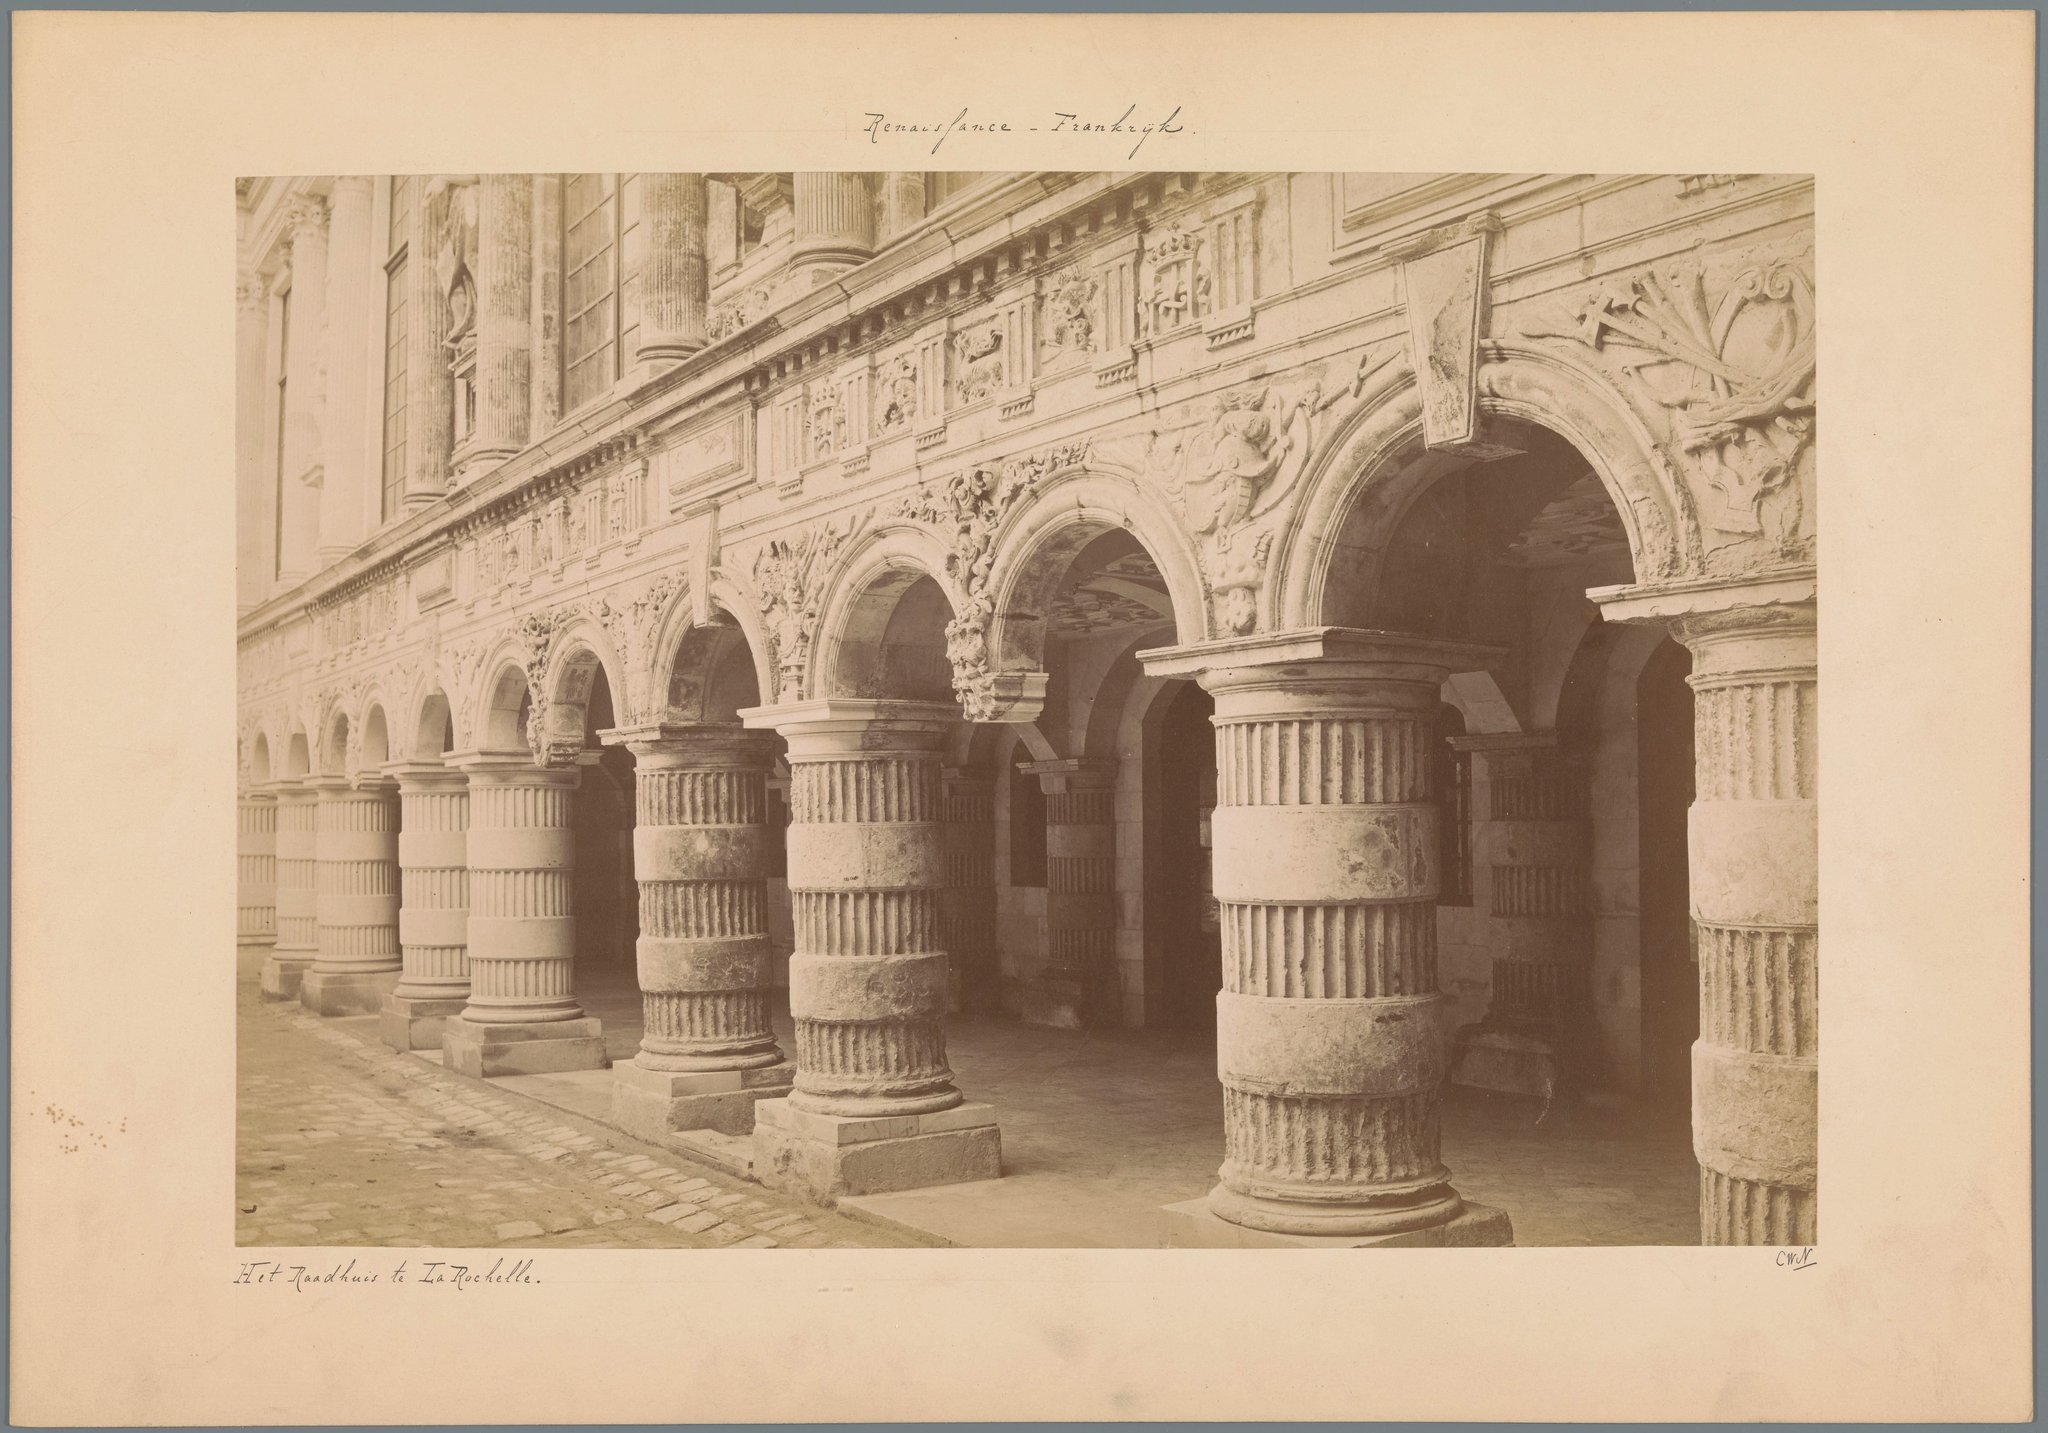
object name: photograph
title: Zuilenrij van het stadhuis van La Rochelle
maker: Anonymous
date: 1875-1900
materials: cardboard, photographic support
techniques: albumen print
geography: la rochelle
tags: column, pillar ~ architecture, townhall, façade (of house or building), arcade ~ architecture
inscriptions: inscription: ‘Renaissance - Frankrijk. Het Raadhuis te La Rochelle.’, collector's mark: ‘KUNSTNIJVERHEIDSCHOOL QUELLINUS AMSTERDAM FRANS HALSSTRAAT 14.’, collector's mark: ‘INSTITUUT VOOR KUNST- NIJVERHEIDSONDERWIJS GABRIËL METSUSTRAAT No. 16. AMSTERDAM’, inscription: ‘CWN.’, inscription: ‘MONUMENTS HISTORIQUES’